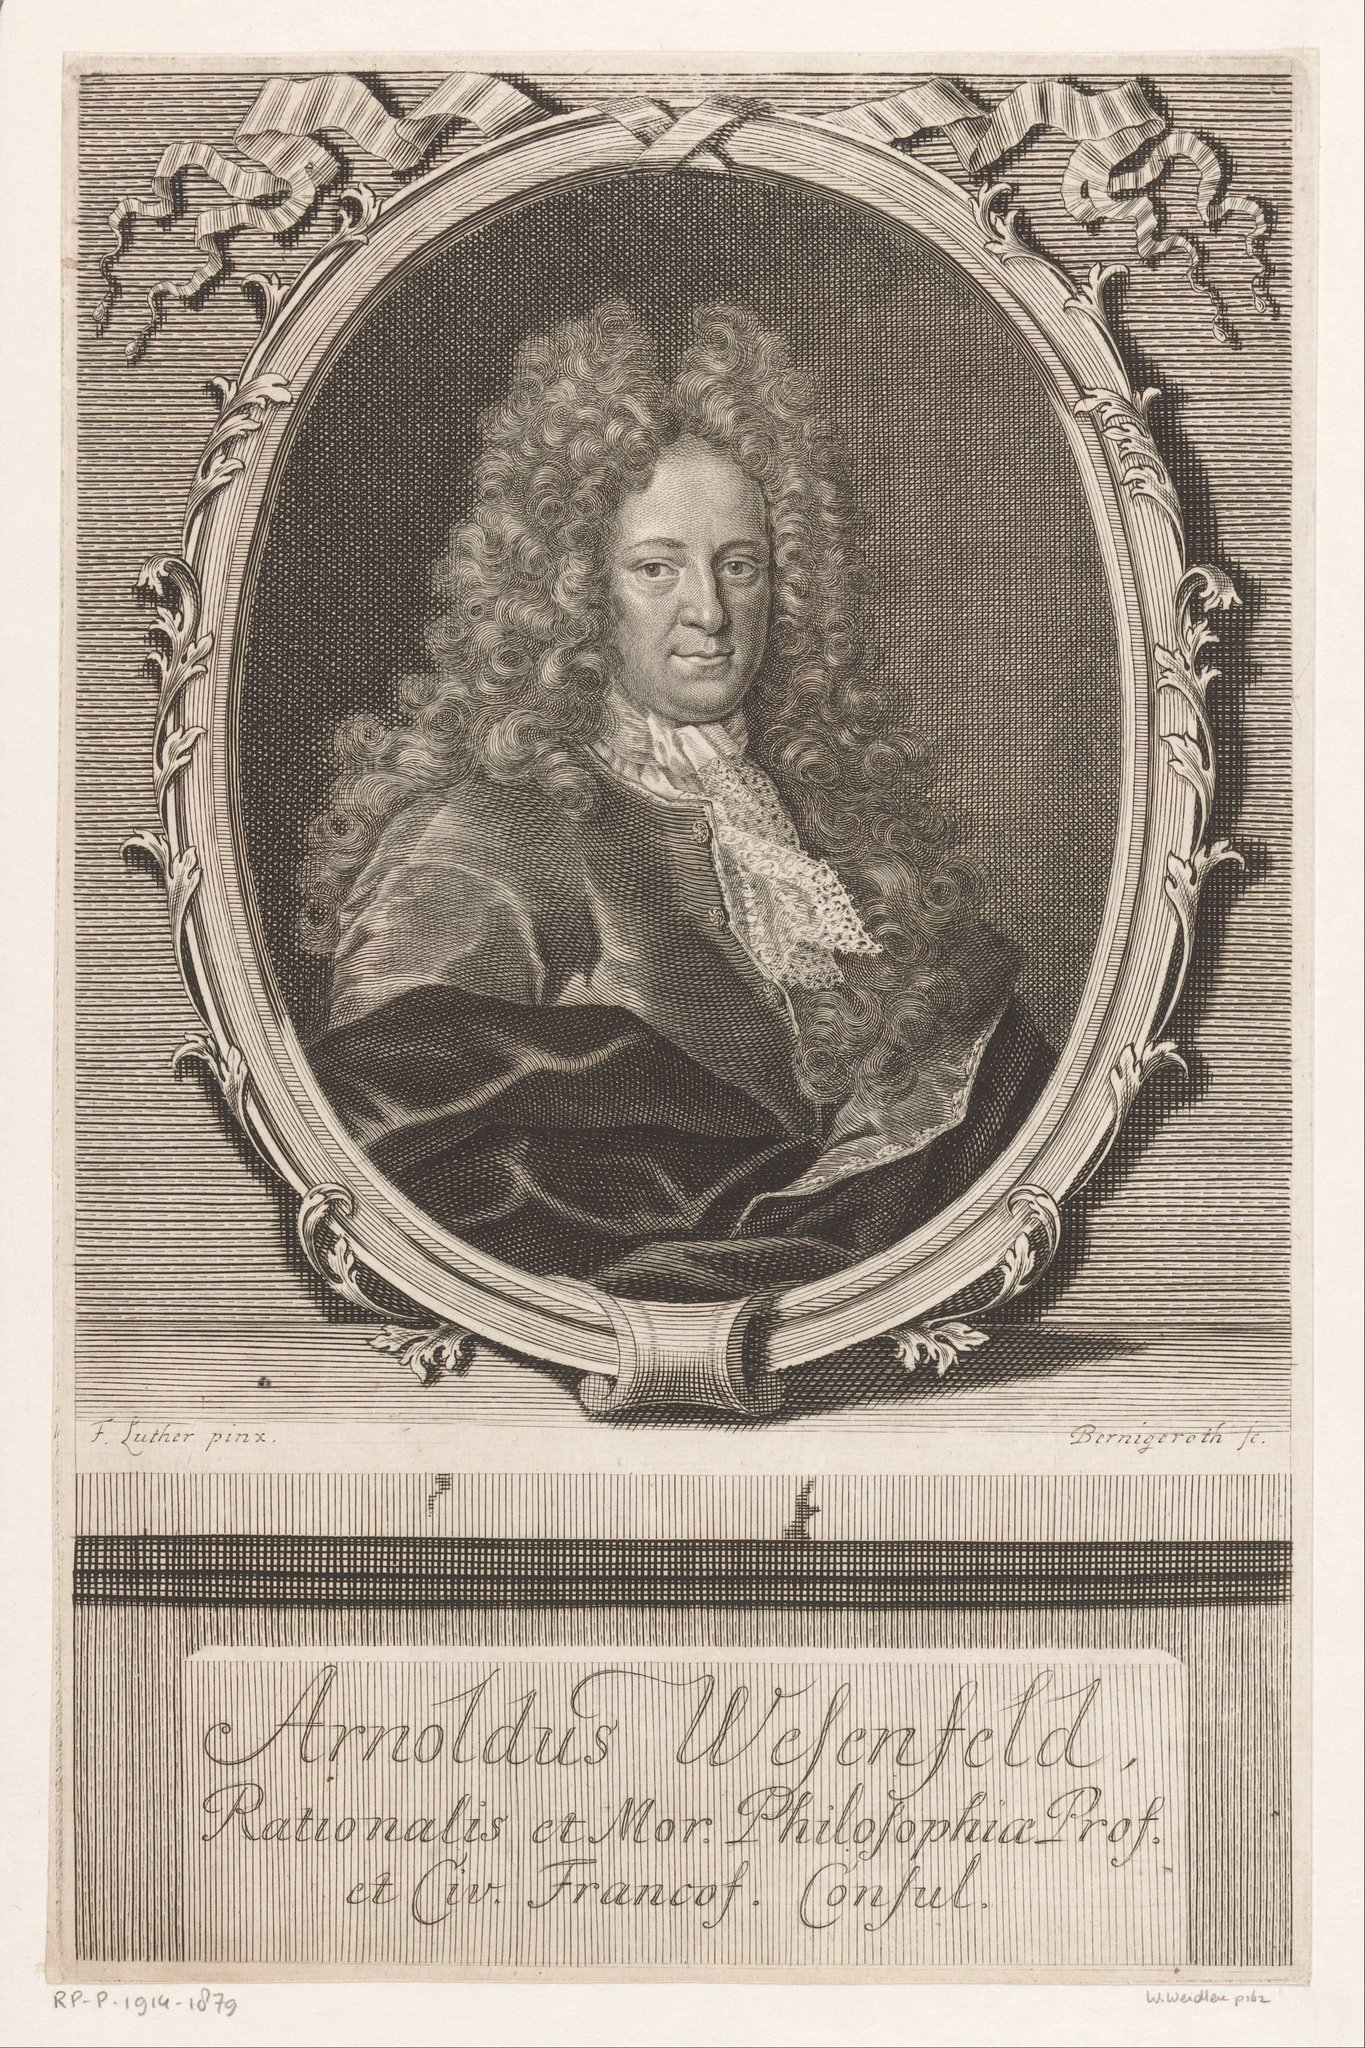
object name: print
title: Portret van Arnold Wesenfeld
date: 1707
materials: paper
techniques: engraving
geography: leipzig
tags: historical persons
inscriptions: collector's mark: Lugt 2228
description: Prent ook gebruikt in: Beckmann, Johann Christoph. Notitia Universitatis Francofurtanae (...). Frankfurt an der Oder: erven Jeremias Schrey en Johann Christoph Hartmann, 1707, p. 74.